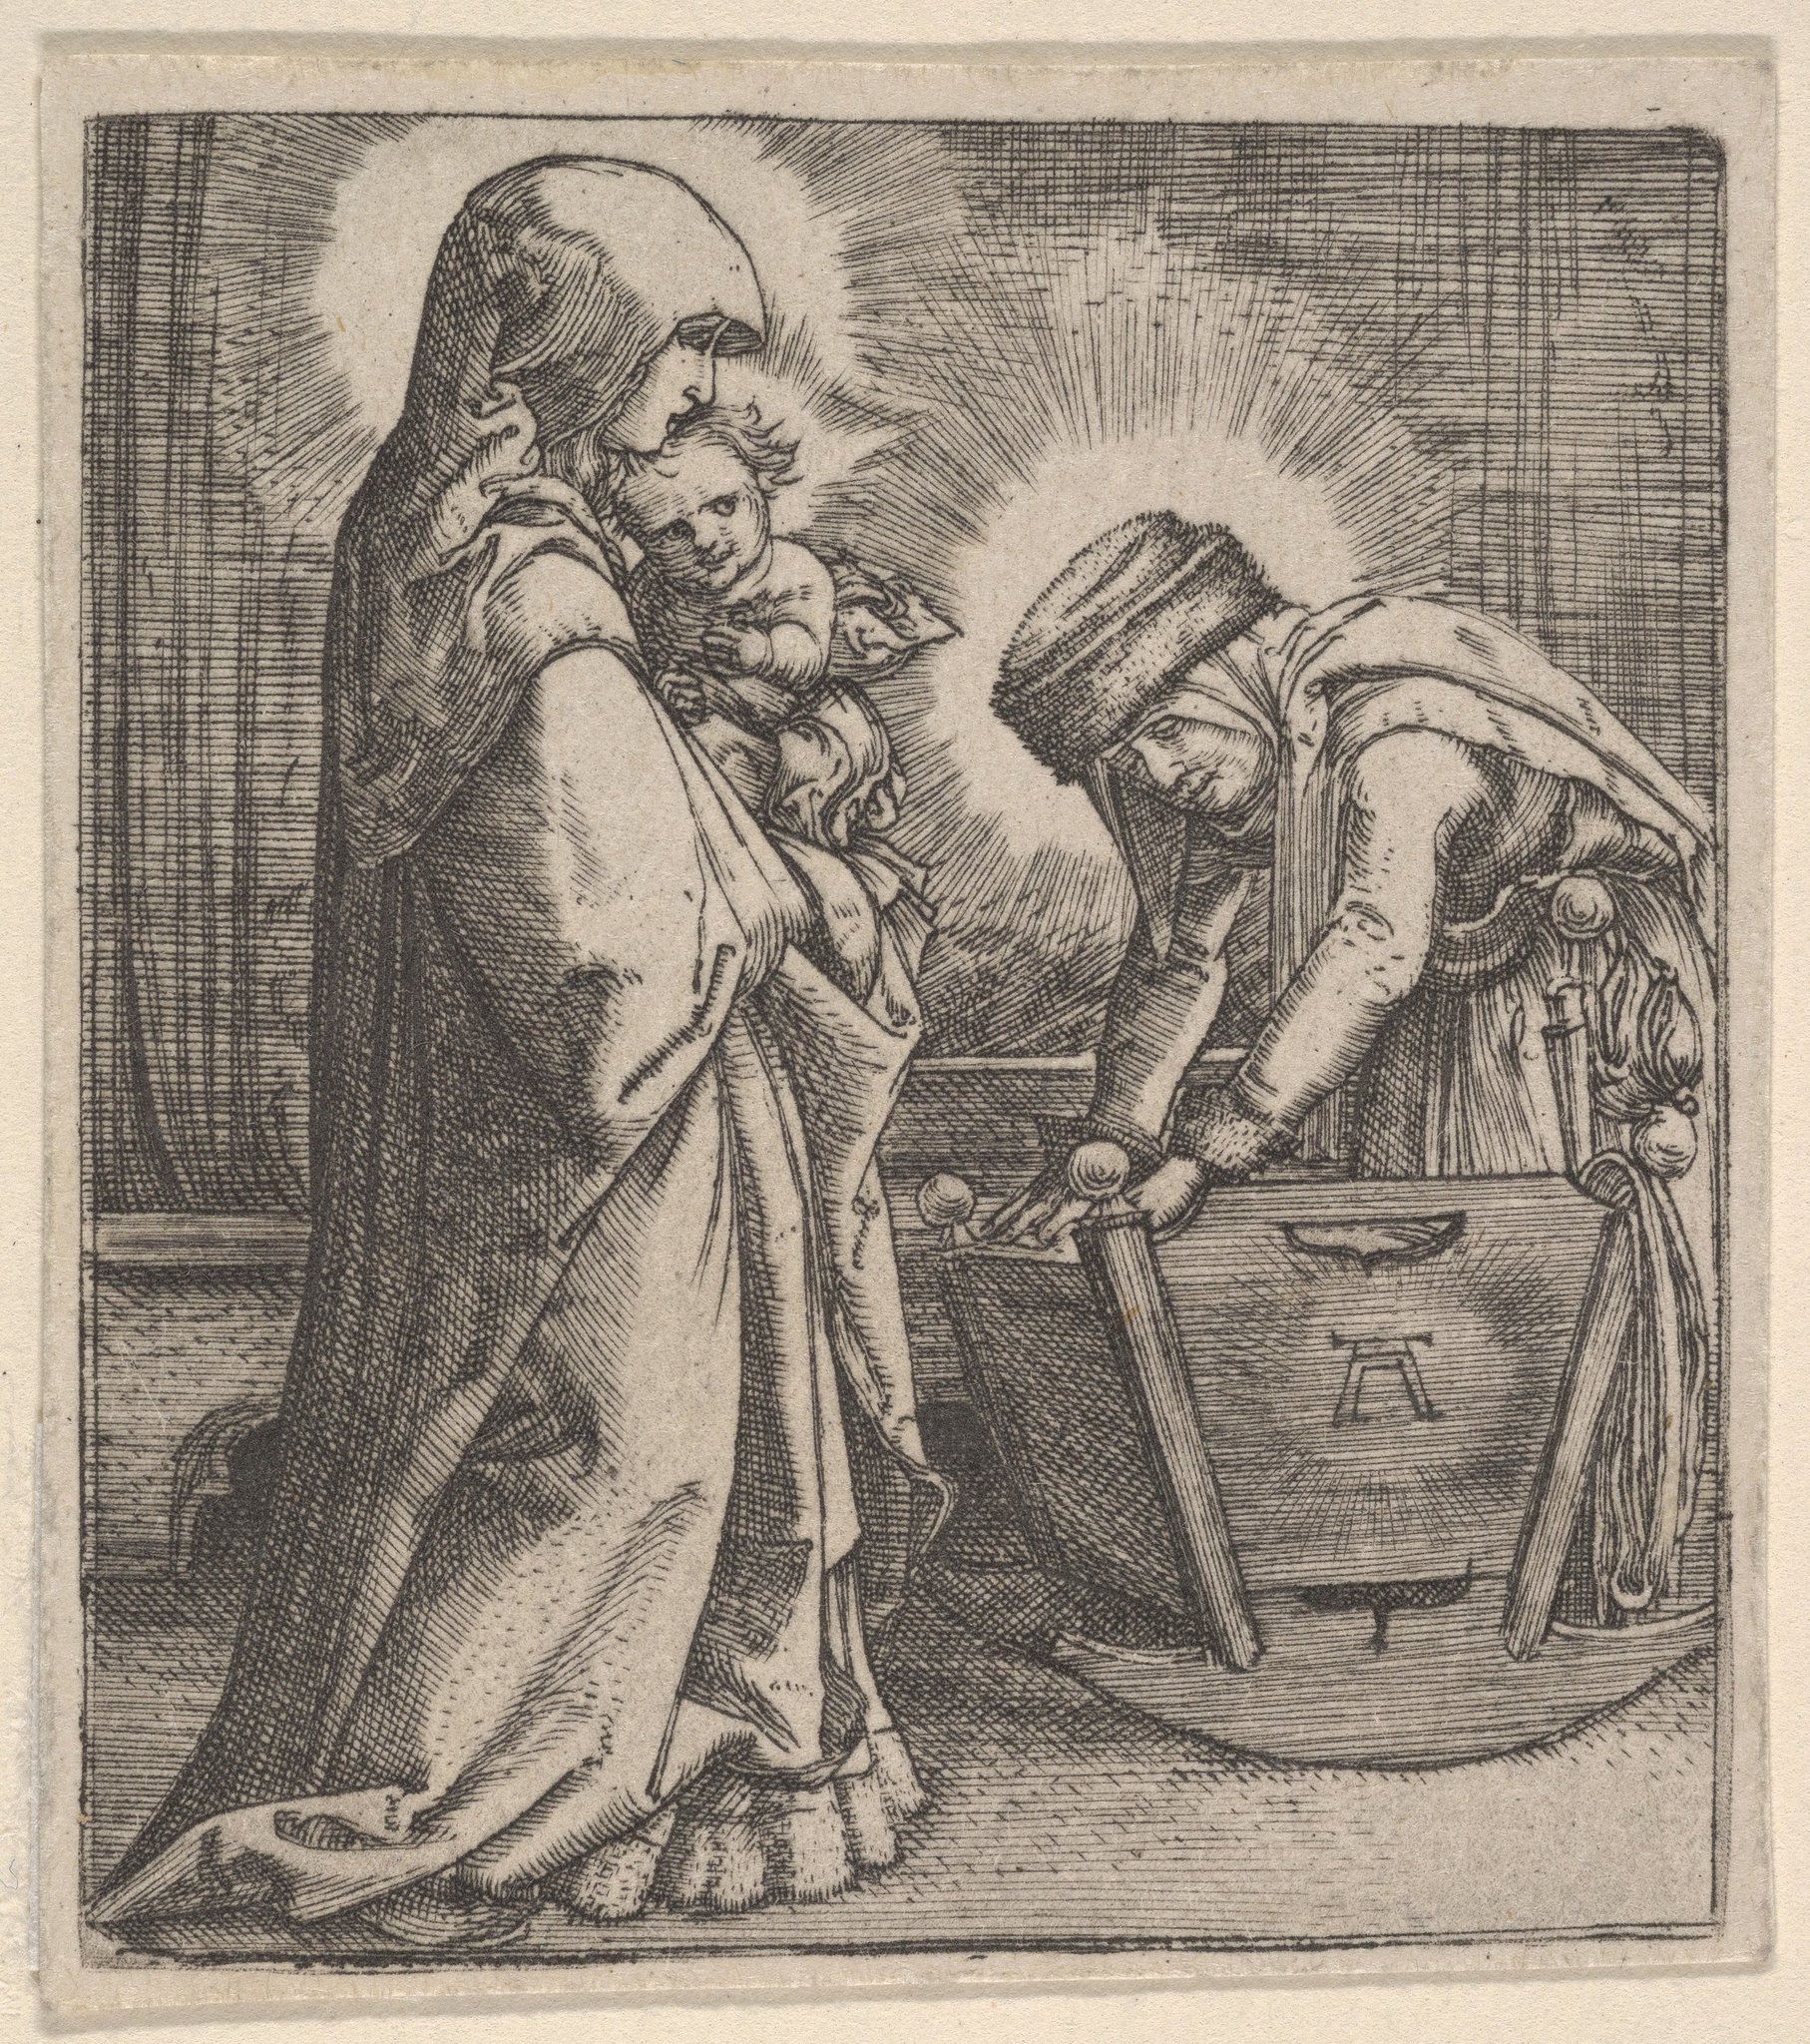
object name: print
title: Copy of The Virgin and Child with Saint Anne at the Cradle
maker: albrecht altdorfer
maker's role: artist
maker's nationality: german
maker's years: 1480-1538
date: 1500-1650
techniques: engraving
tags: madonna and child,saint anne,cradles